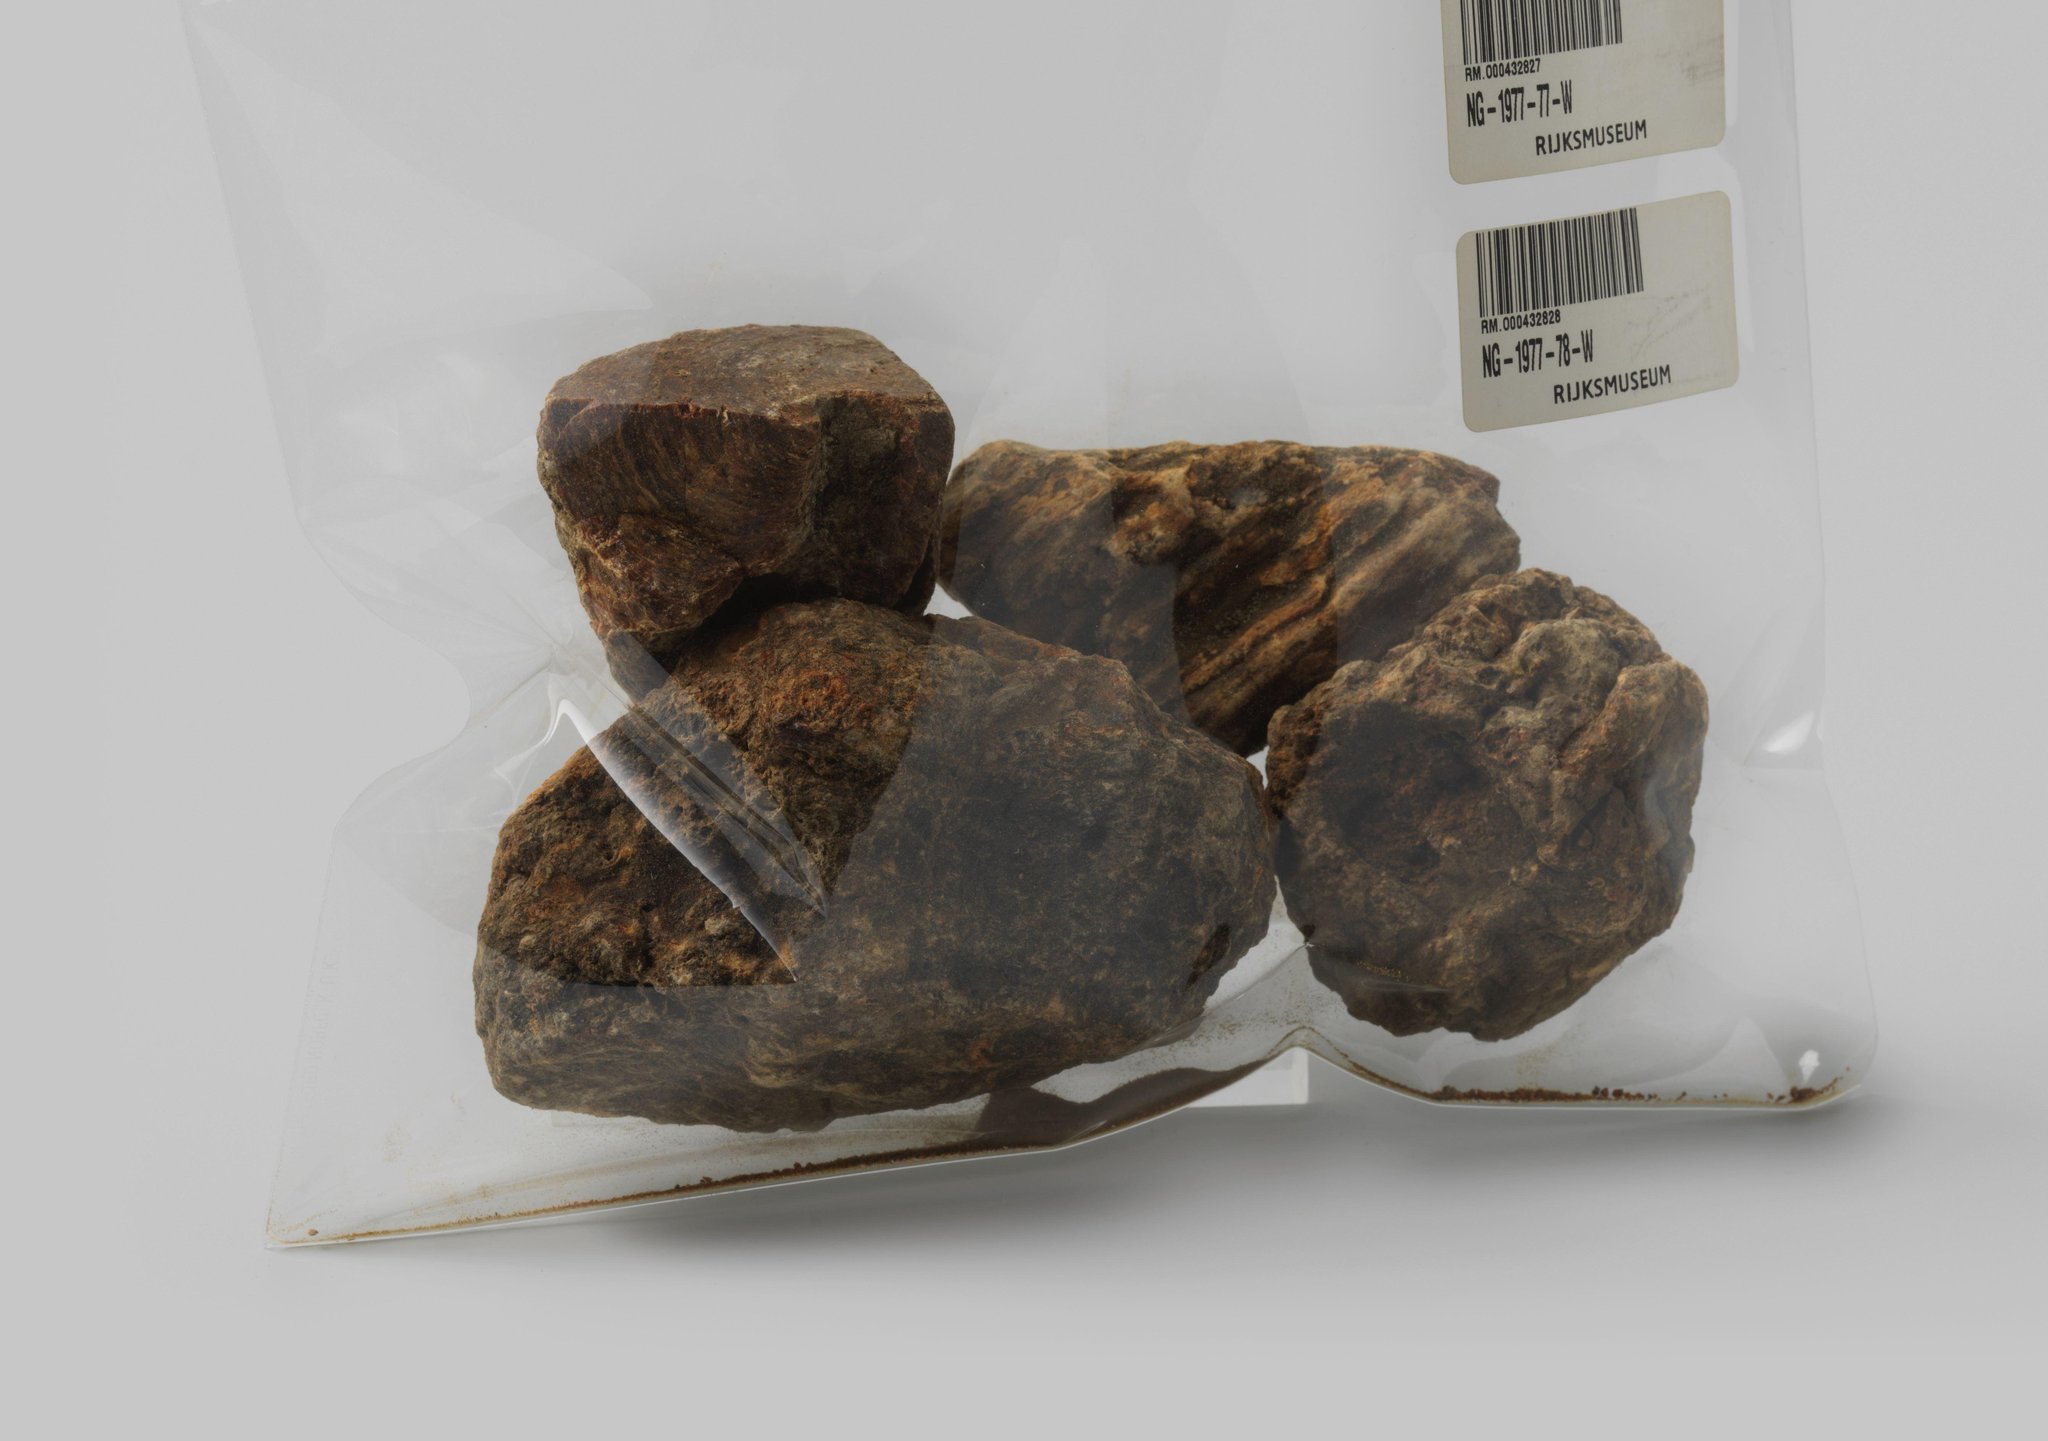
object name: artifact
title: Brok uit V.O.C.-schip de 'Witte Leeuw'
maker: Anonymous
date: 1613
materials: pigment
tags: verenigde oostindische compagnie, sint-helena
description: Brok uit V.O.C.-schip de 'Witte Leeuw', loodwit, grondstof voor verf.